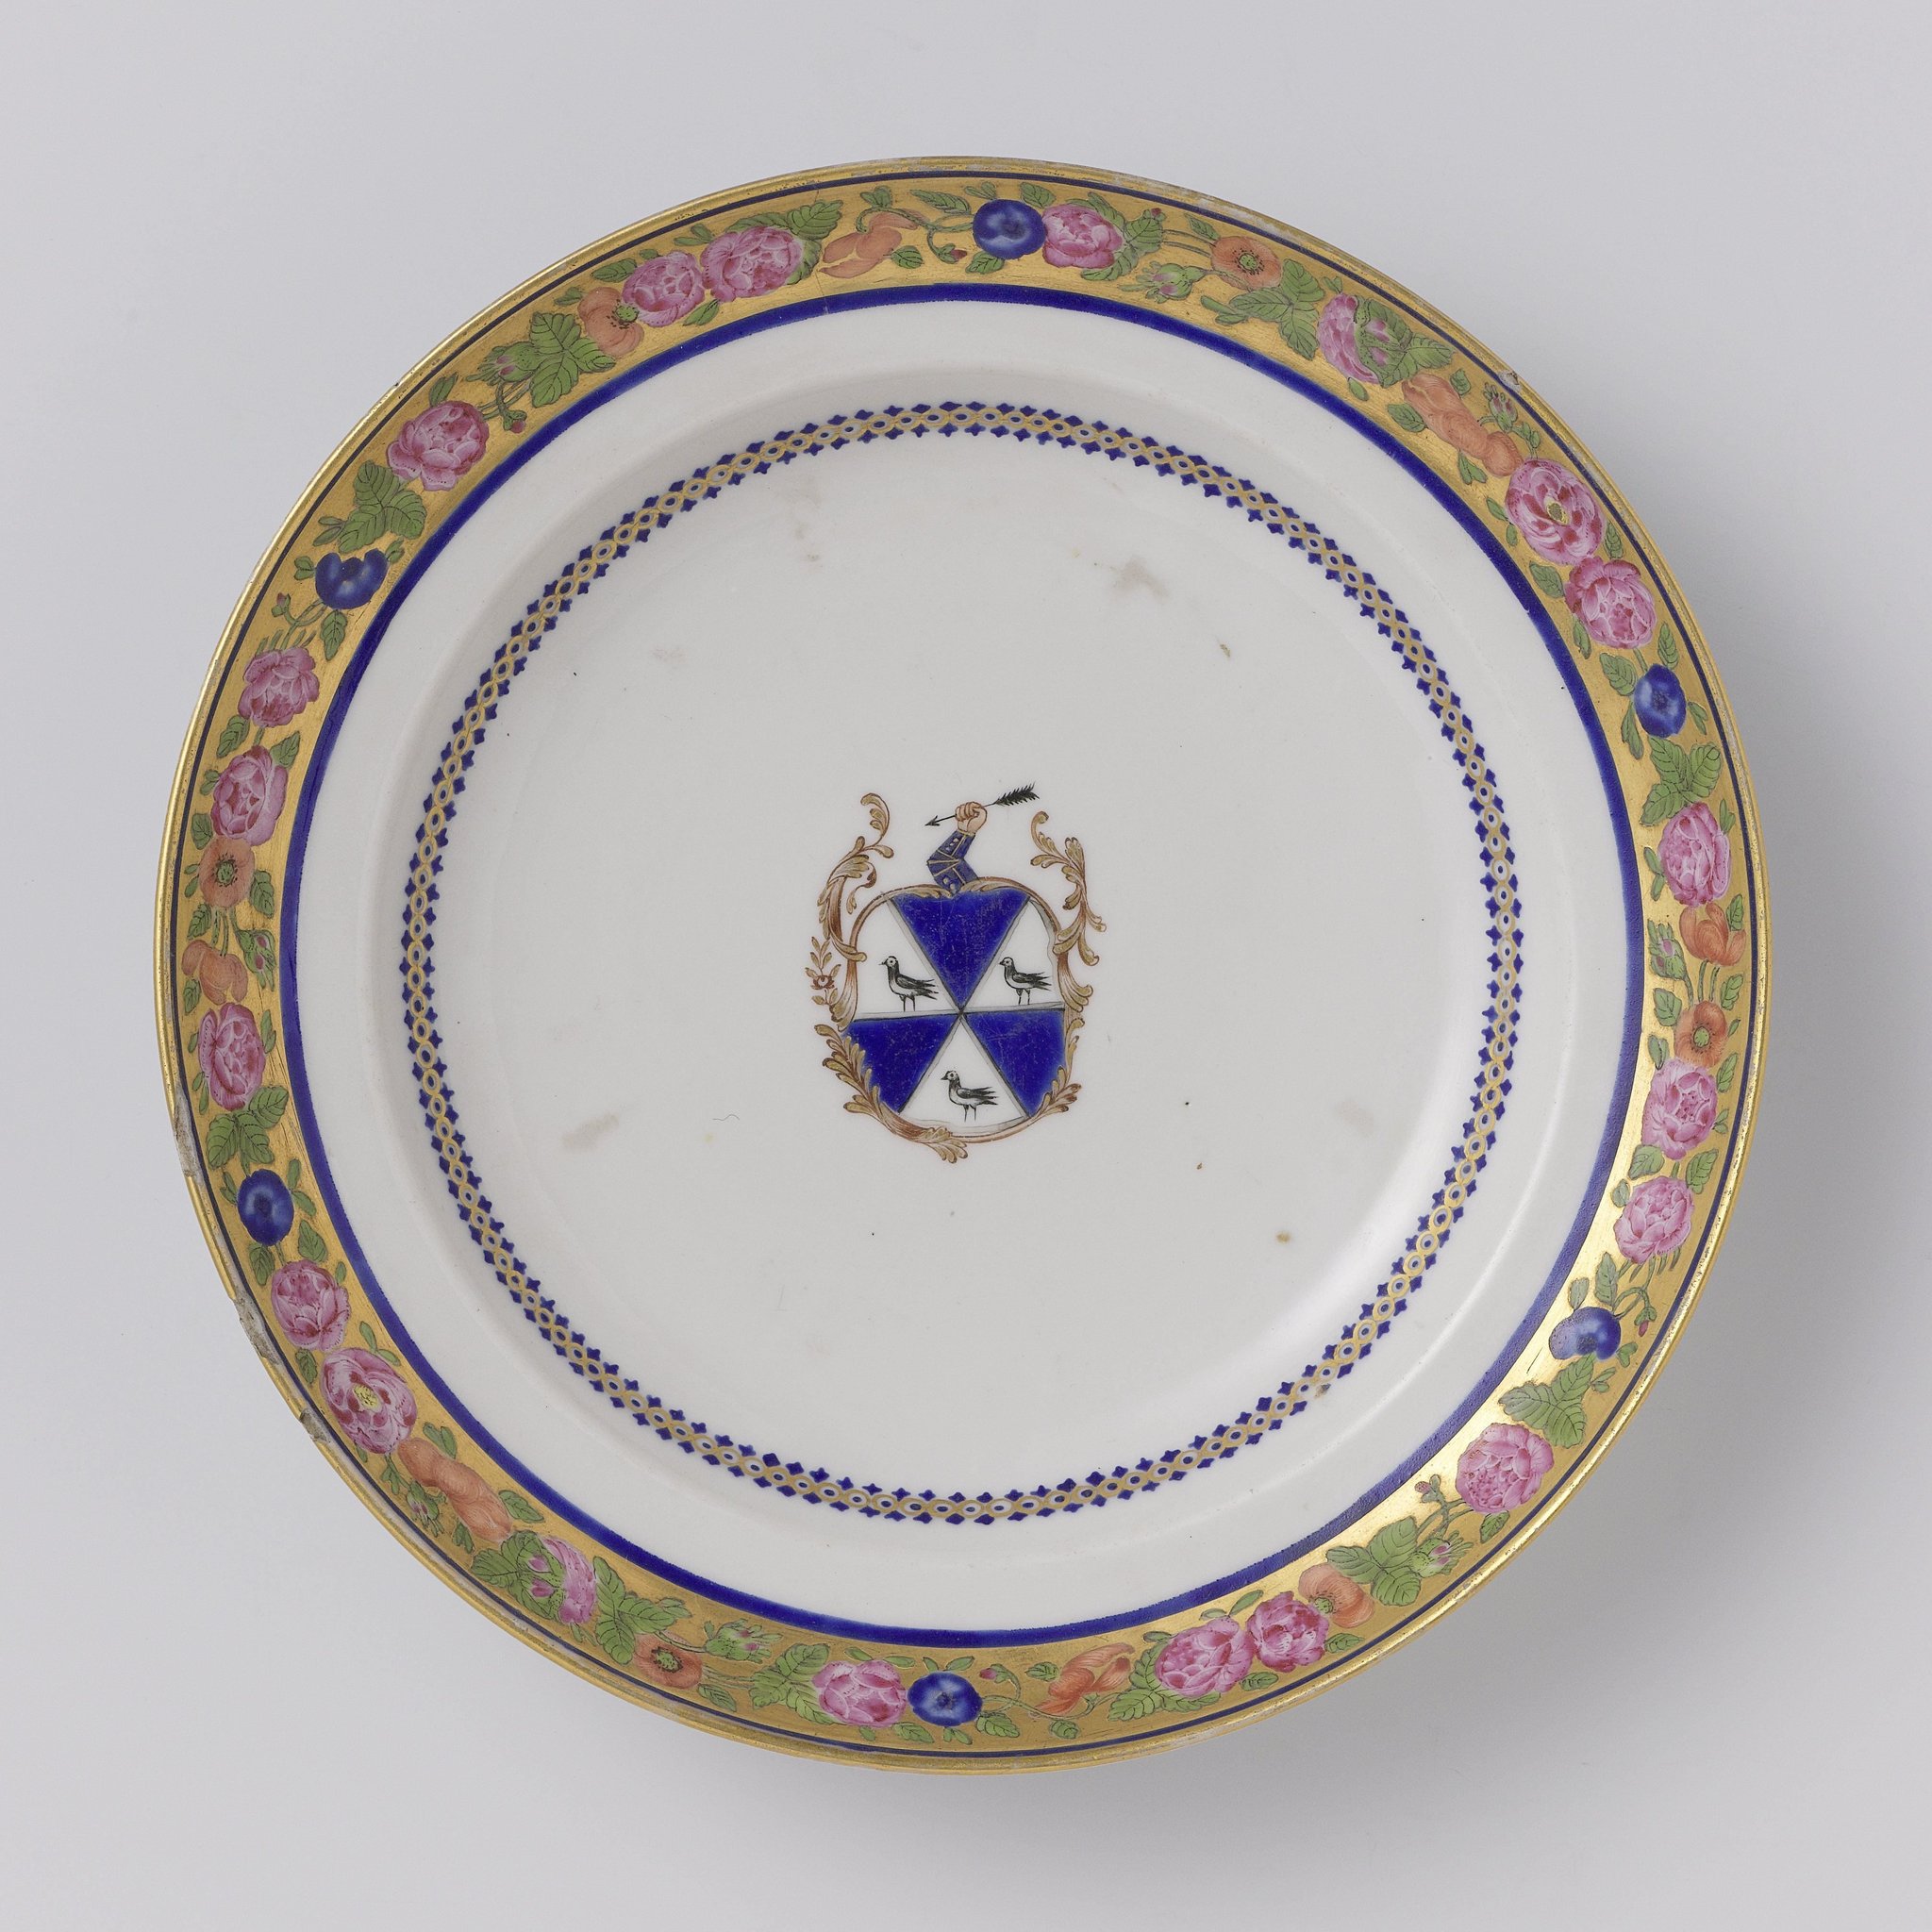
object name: plate dish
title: Plate with the arms of the Stocker or Tatham family and floral scrolls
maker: Anonymous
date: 1775-1799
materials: glaze, gold, paint, porcelain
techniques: firing, gilding, turning, vitrification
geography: china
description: Bord van porselein, beschilderd op het glazuur in blauw, rood, roze, groen, zwart en goud. Op het plat het wapen van de familie Stocker or Tatham bestaande uit drie blauwe driehoeken en drie gevuld met een vogel, het wapen is omgeven door bladranken met aan de bovenzijde een arm met een pijl. Op de wand een decoratieve band; de rand met bloem- en fruitranken tegen een gouden grond. Enkele chips in de rand. Wapenporselein met emailkleuren.